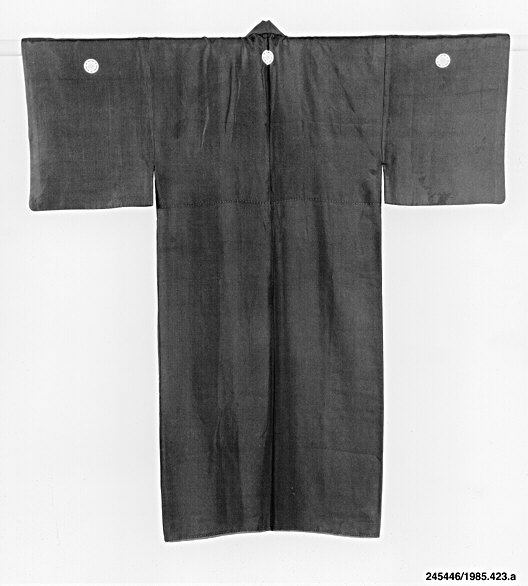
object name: priest costume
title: Costume of Lay Priest (Komuzo)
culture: japanese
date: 1901-1950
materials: silk